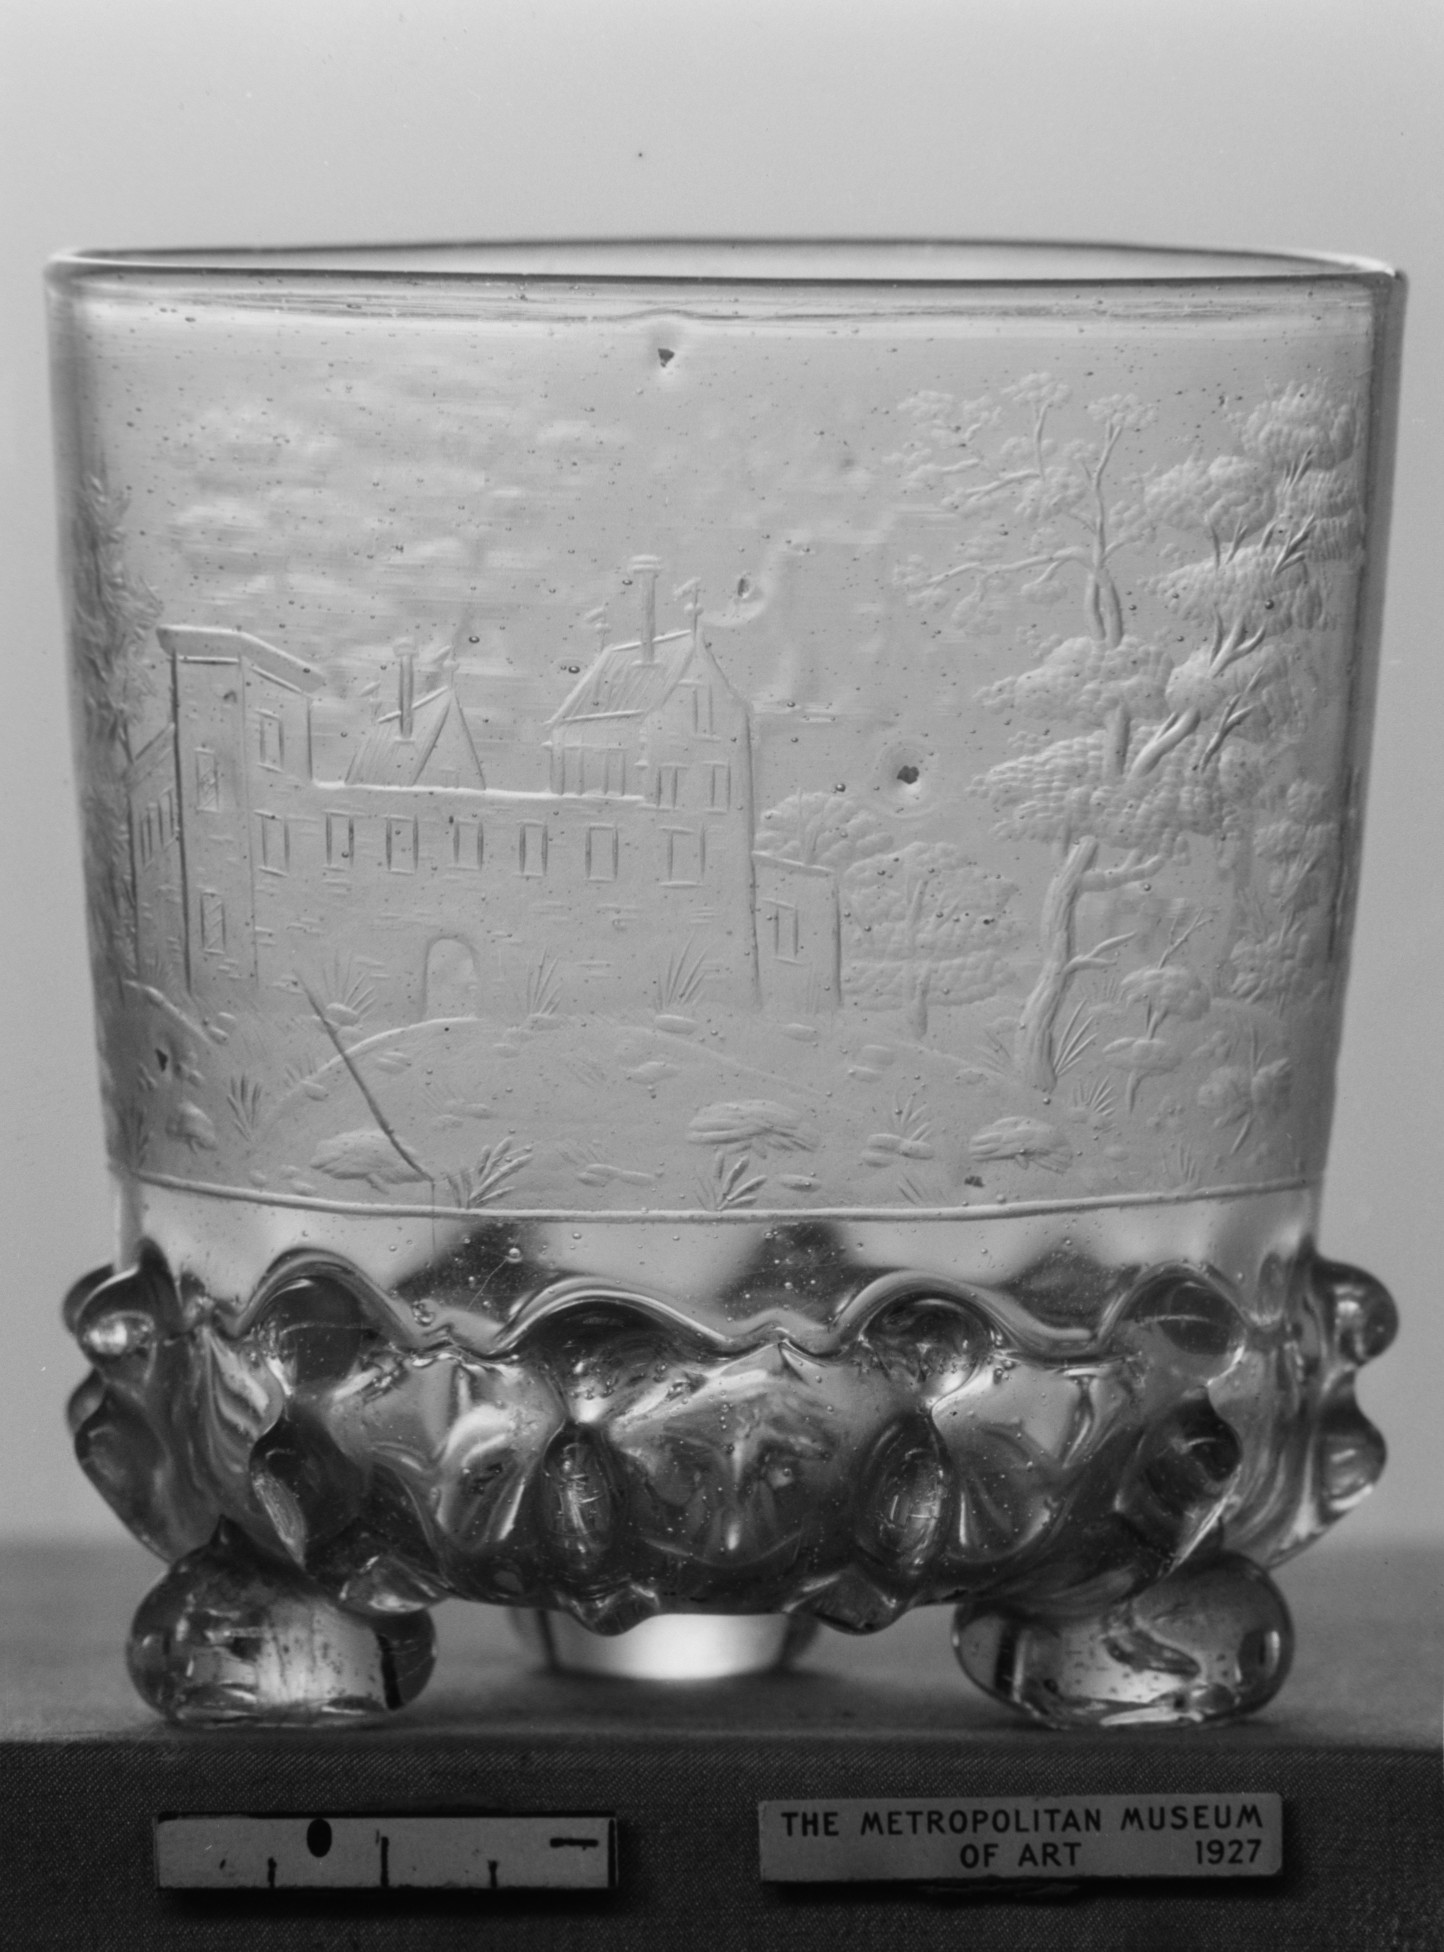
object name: beaker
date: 1667-1700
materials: glass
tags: houses